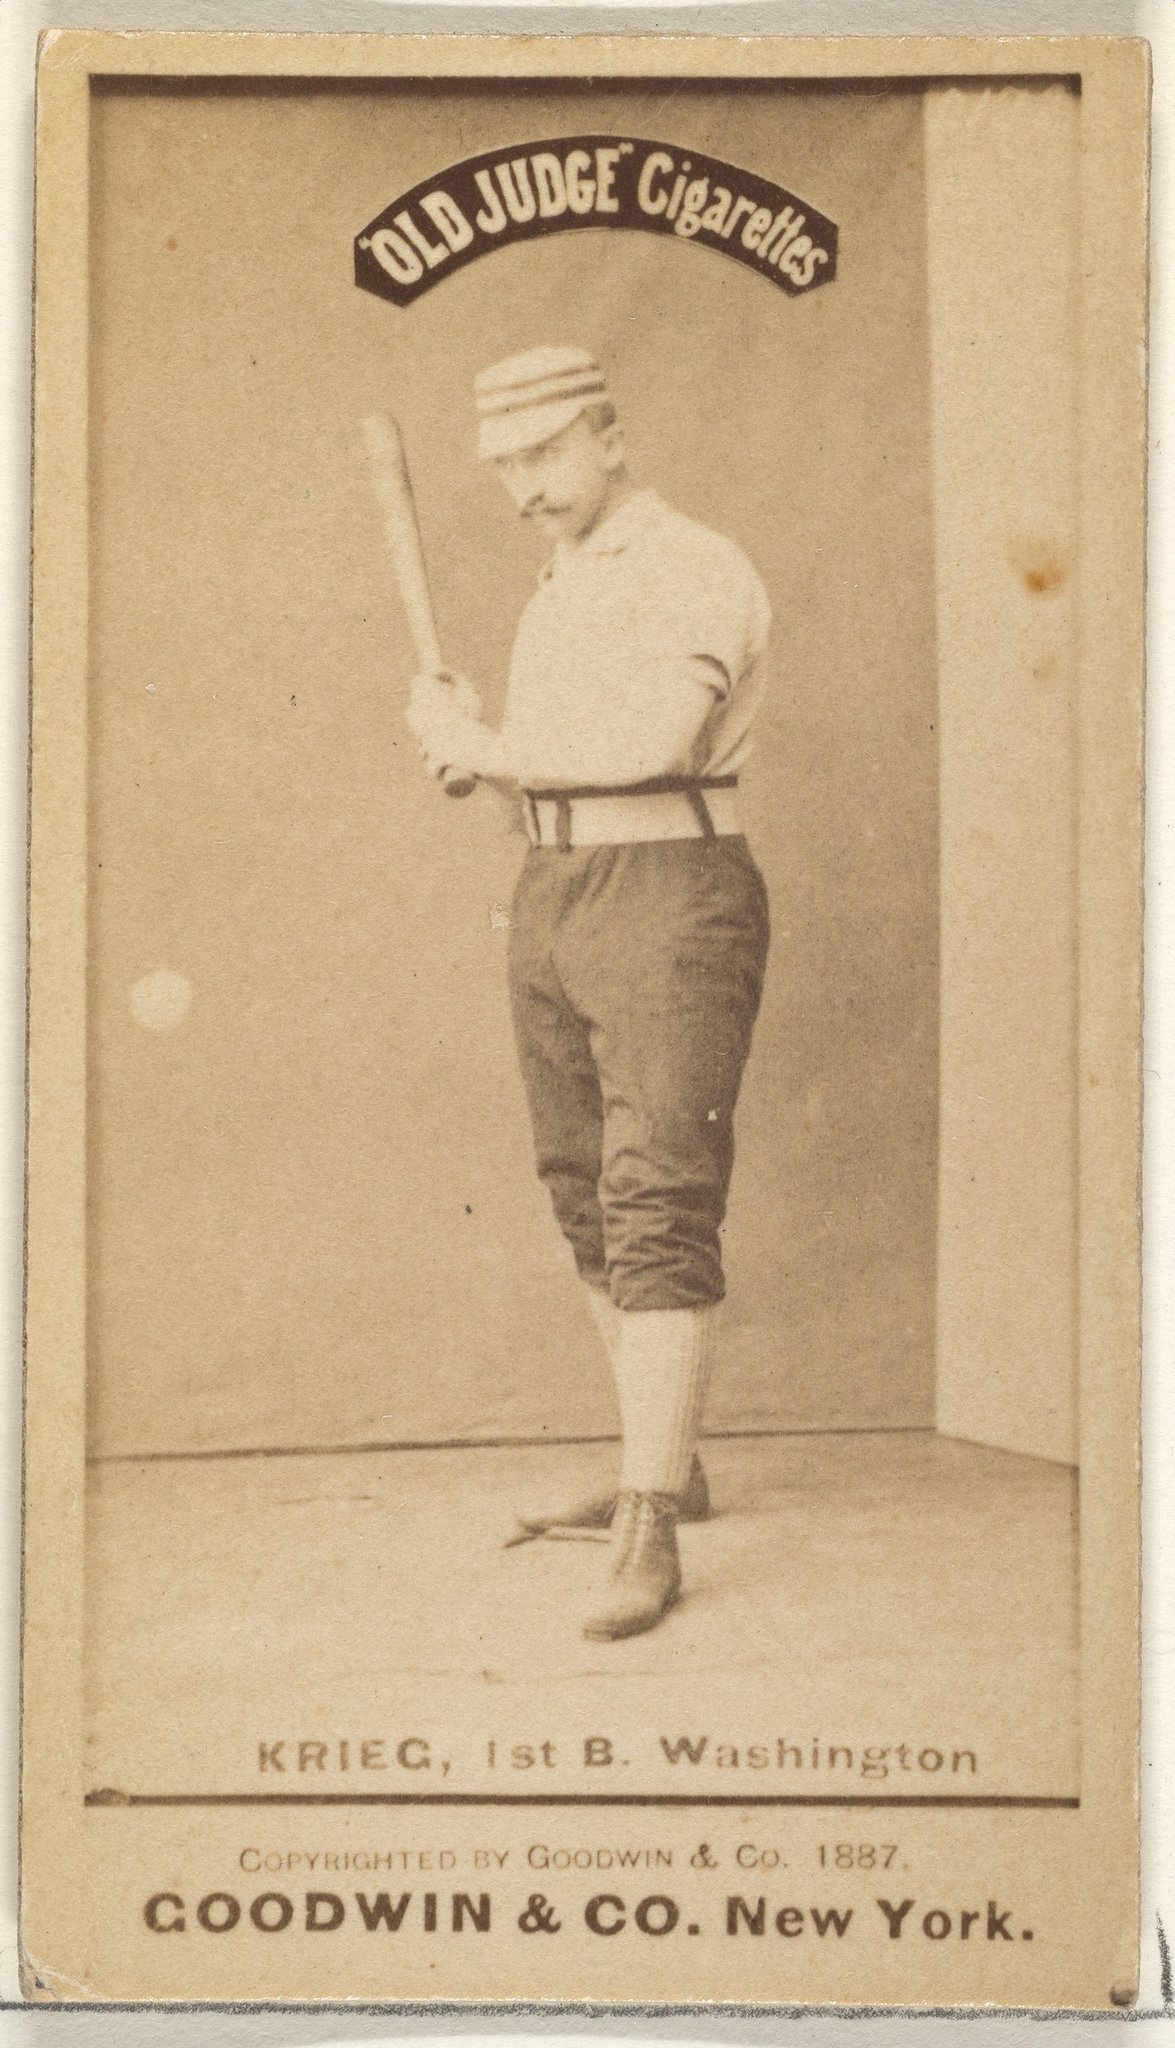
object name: baseball card, photograph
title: William "Bill" Frederick Krieg, 1st Base, Washington Nationals, from the Old Judge series (N172) for Old Judge Cigarettes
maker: goodwin & company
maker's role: publisher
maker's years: 1850-1950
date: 1887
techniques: albumen silver print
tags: men,portraits,baseball,athletes